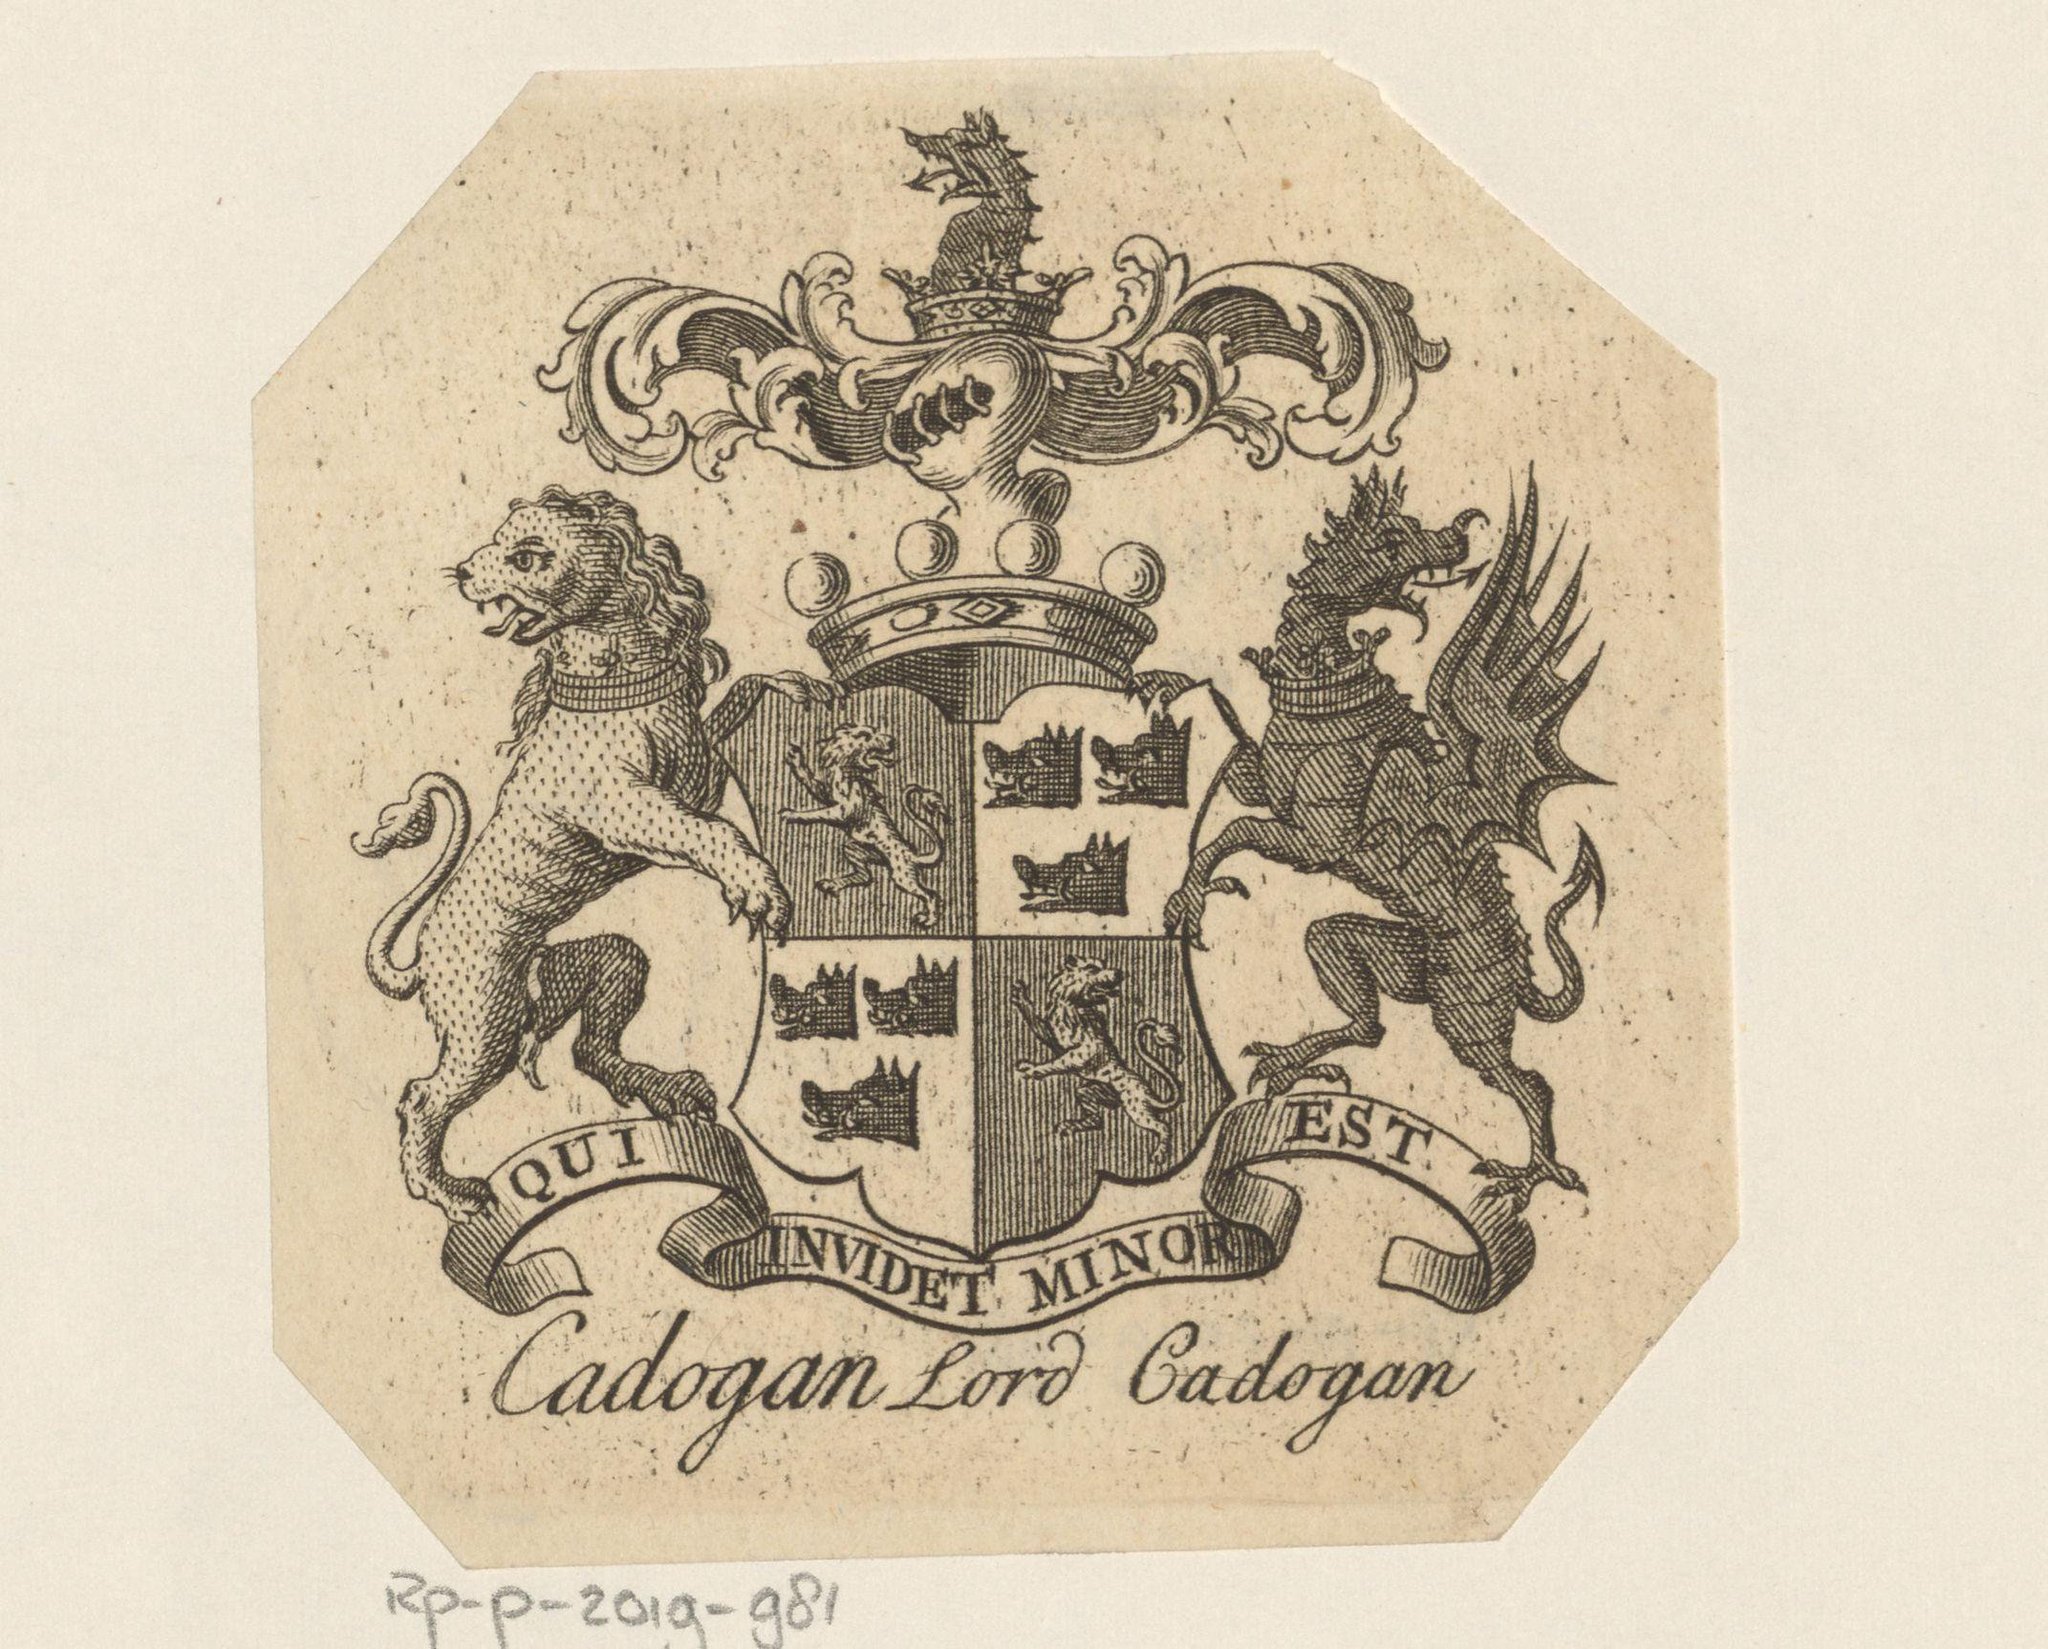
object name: bookplate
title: Ex libris van Cadogan Lord Cadogan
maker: Anonymous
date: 1780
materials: paper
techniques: engraving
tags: armorial bearing, heraldry